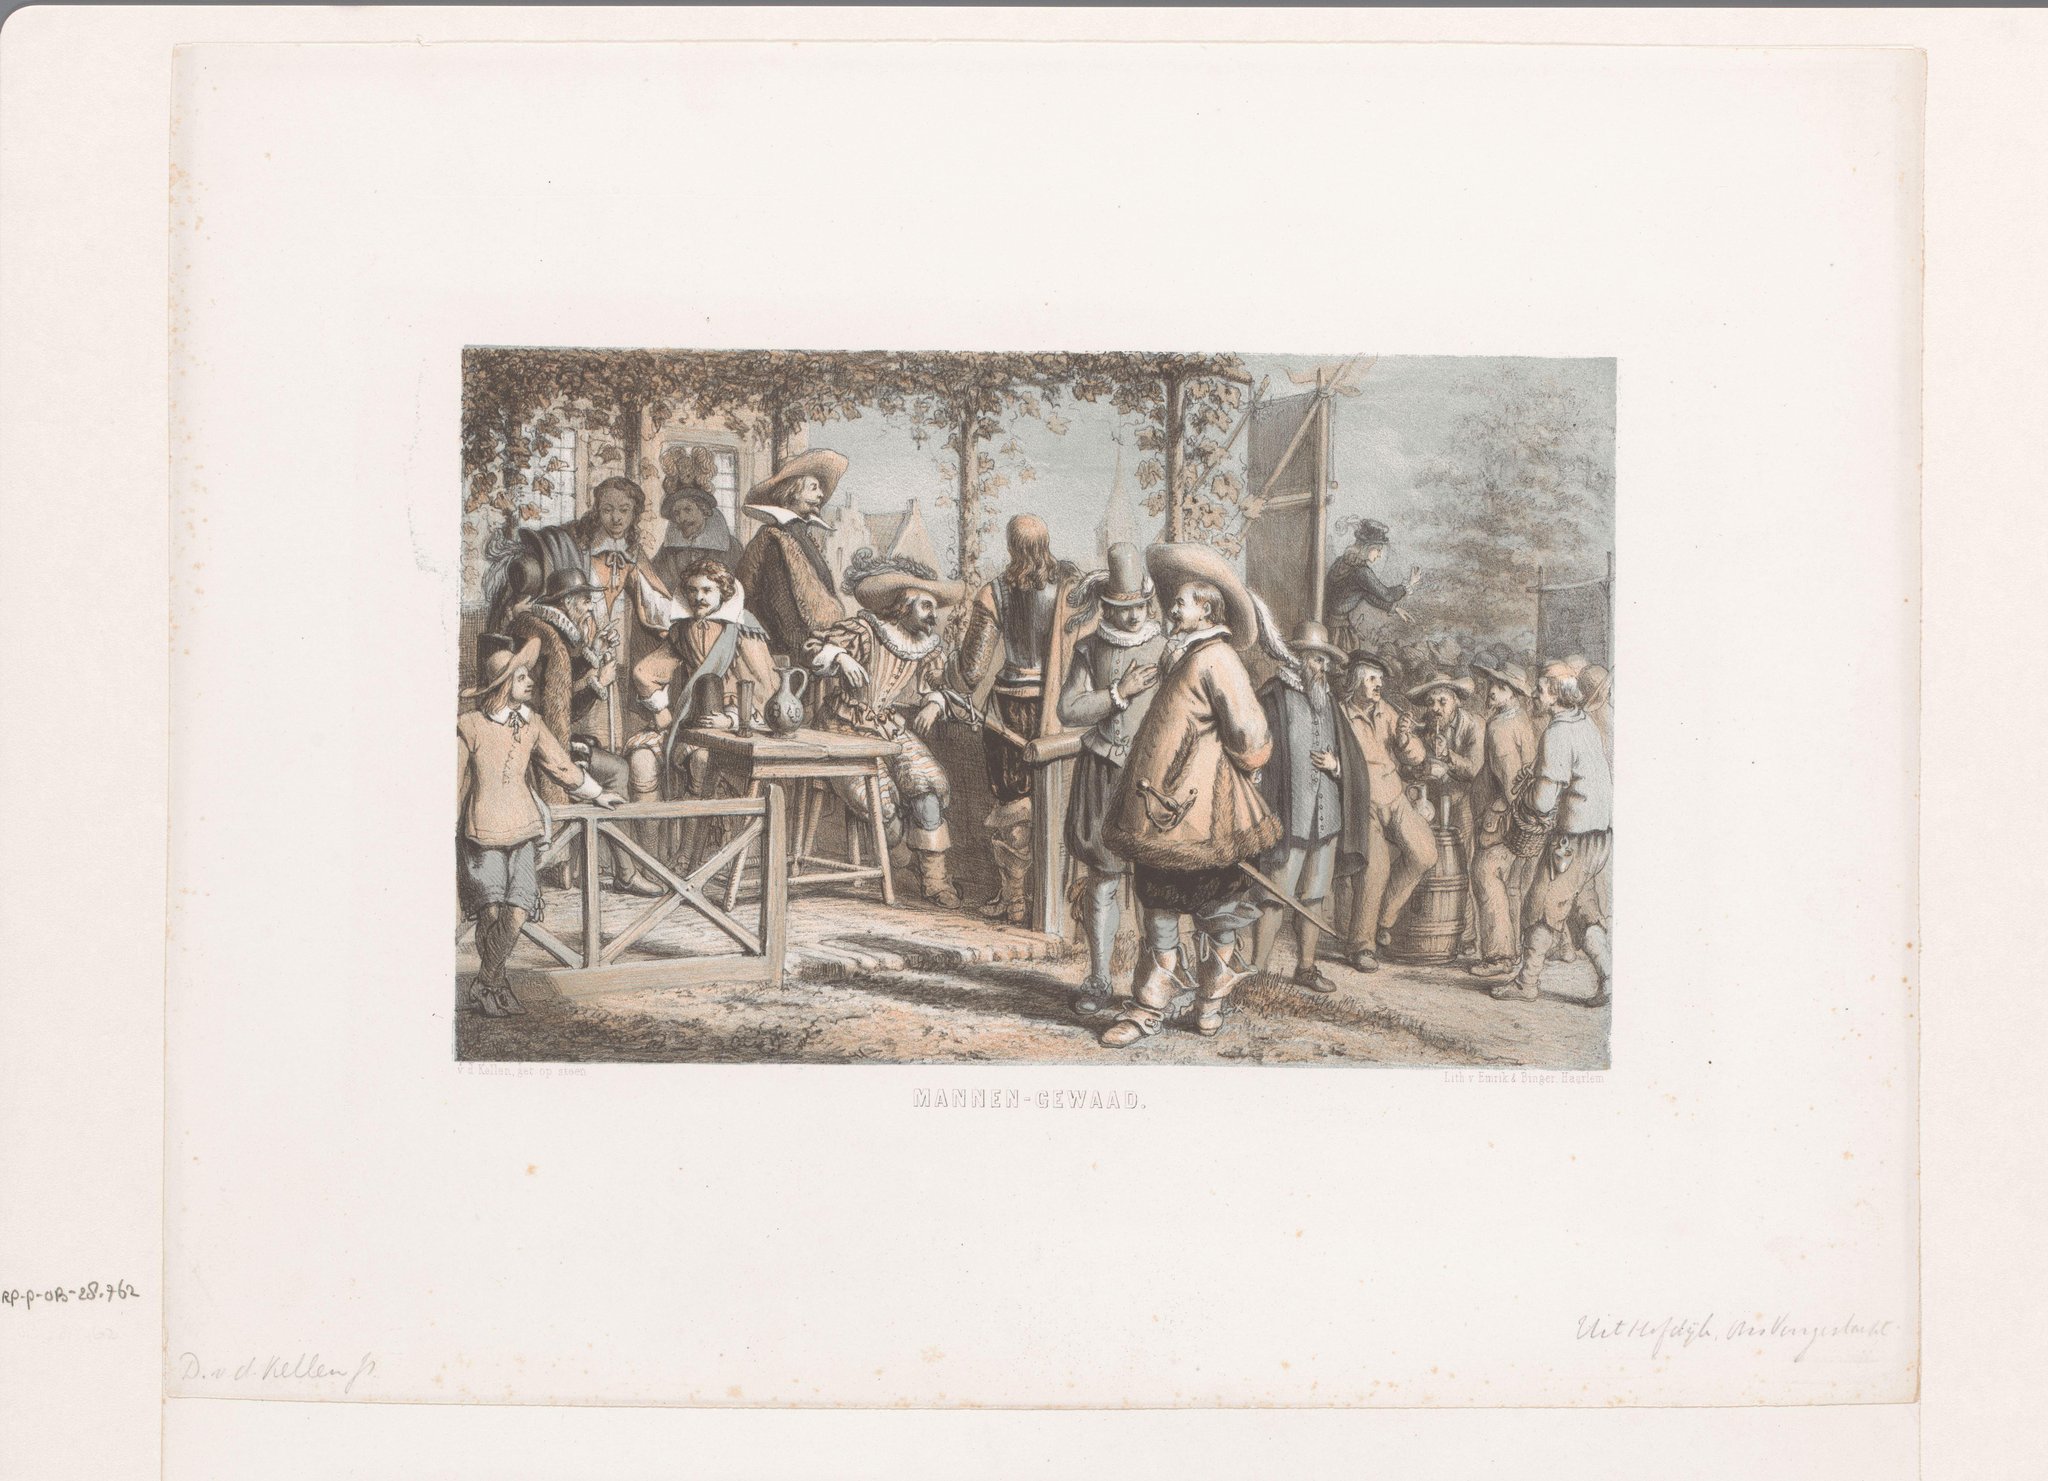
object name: print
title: Mannen-gewaad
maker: david van der kellen (1827-1895)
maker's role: draughtsman, print maker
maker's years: 1827-1895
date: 1859-1864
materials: paper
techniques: tone lithography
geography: haarlem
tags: public festivities, nobility and patriciate; chivalry, knighthood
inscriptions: collector's mark: Lugt 2228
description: Links, gescheiden van de menigte, zitten edelen en welgestelde burgers bij een tafel. Rechts zijn mensen aan het feesten en drinken.